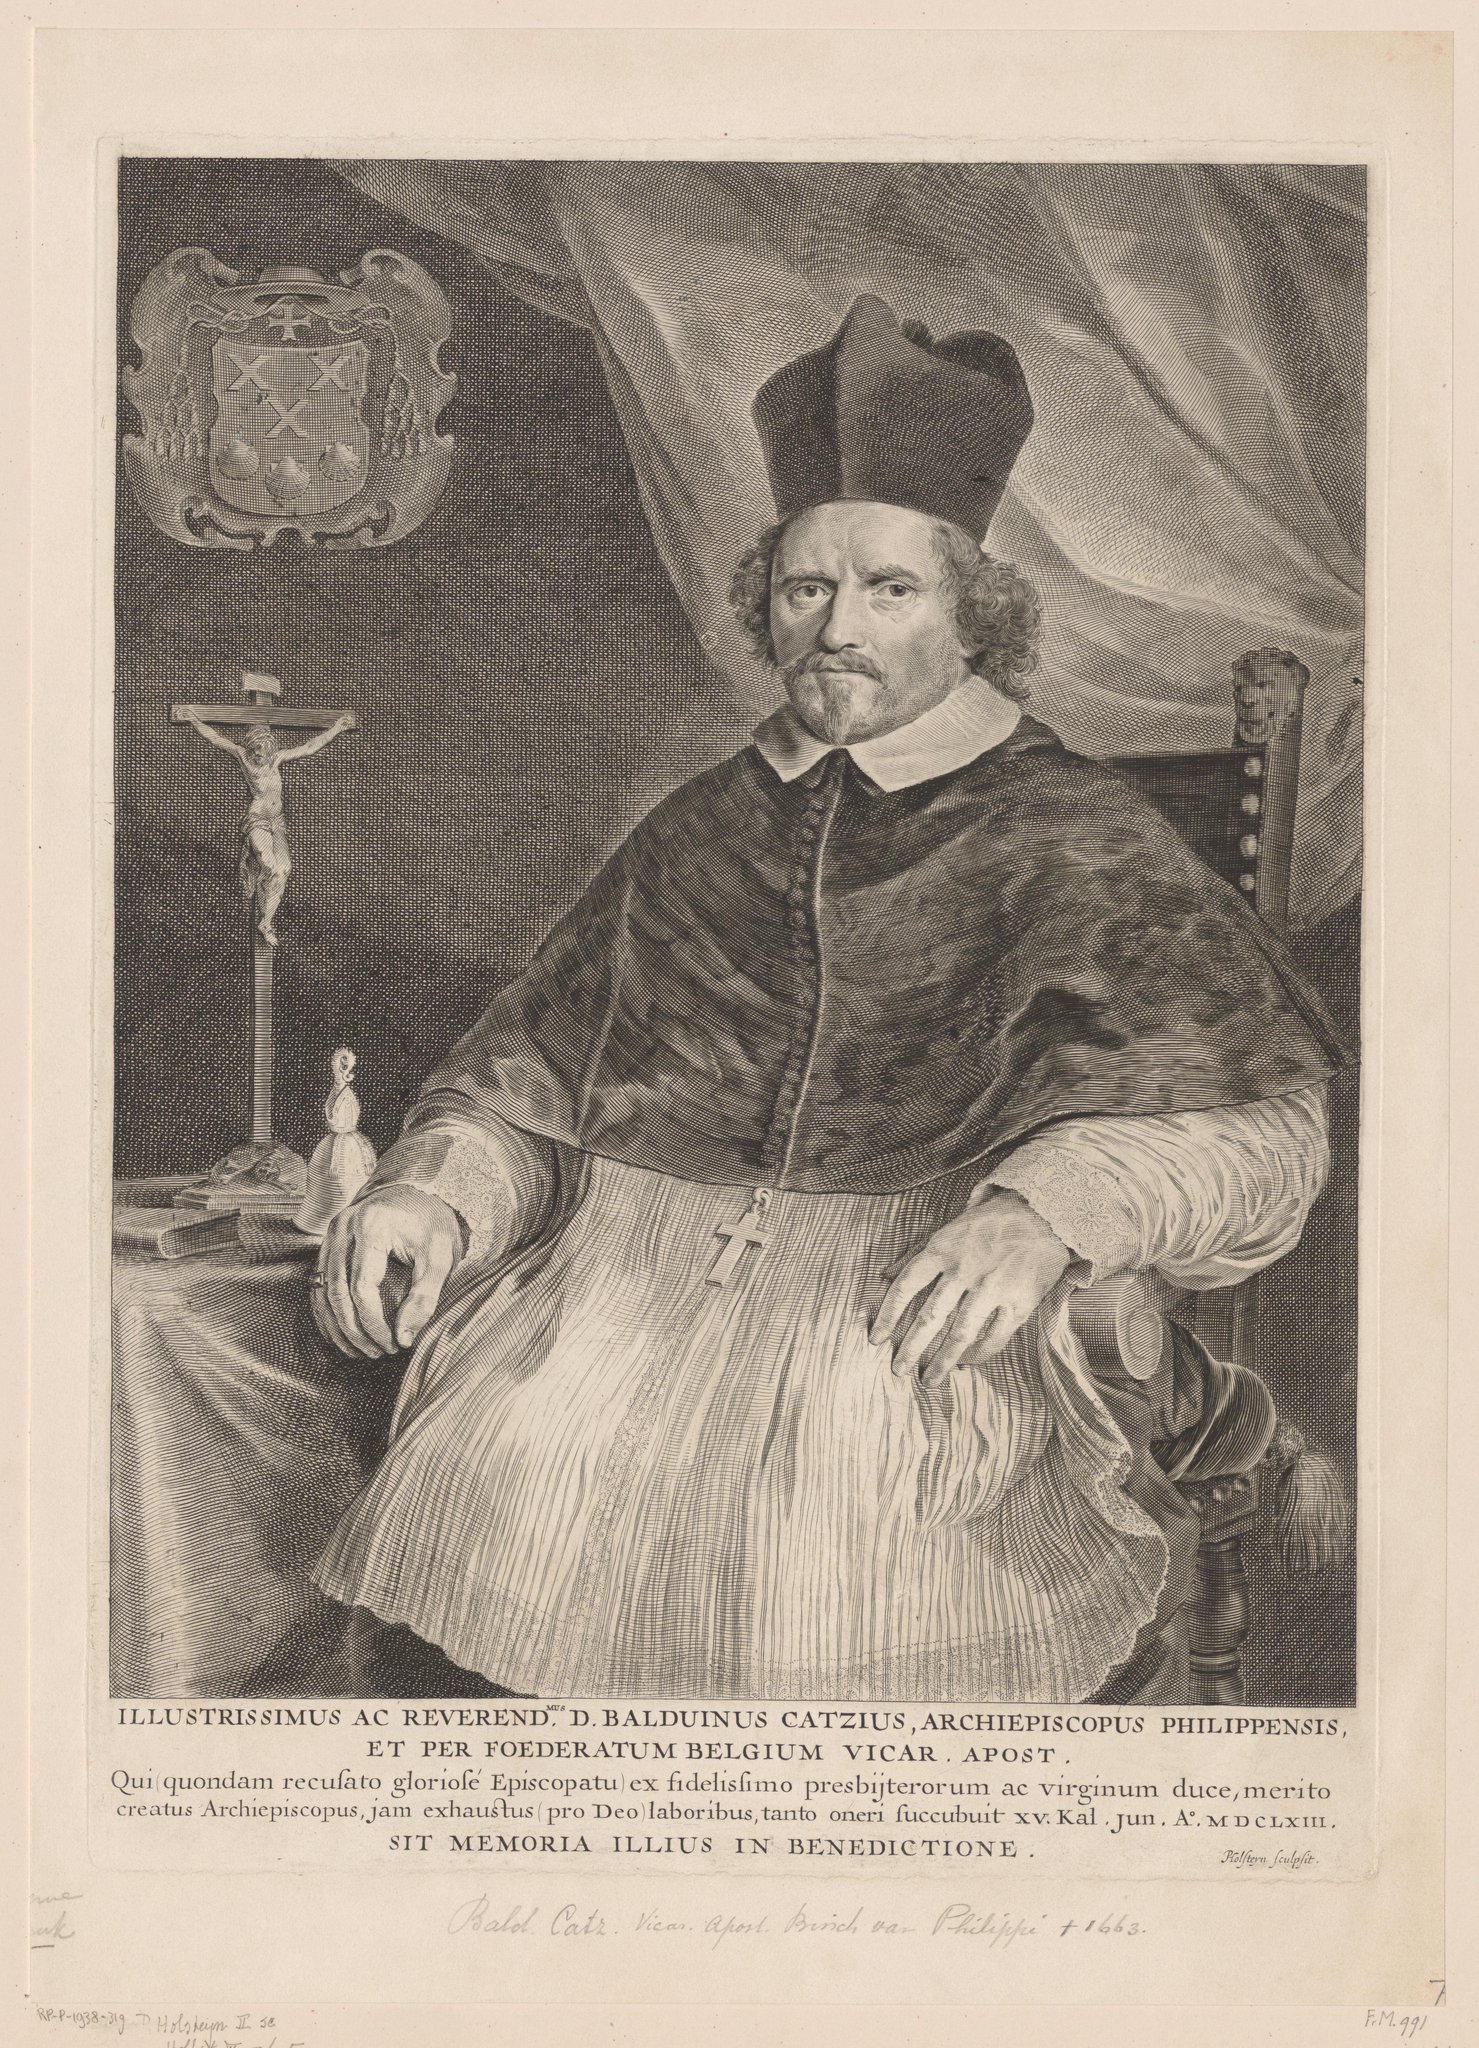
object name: print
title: Portret van Balduinus Cats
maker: pieter holsteyn (ii)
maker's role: draughtsman, print maker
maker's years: 1614-1673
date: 1663-1673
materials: paper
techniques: engraving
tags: archbishop, bishop, etc. (roman catholic), historical persons, armorial bearing, heraldry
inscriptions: collector's mark: Lugt 2228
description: Linksboven het portret zijn wapenschild.